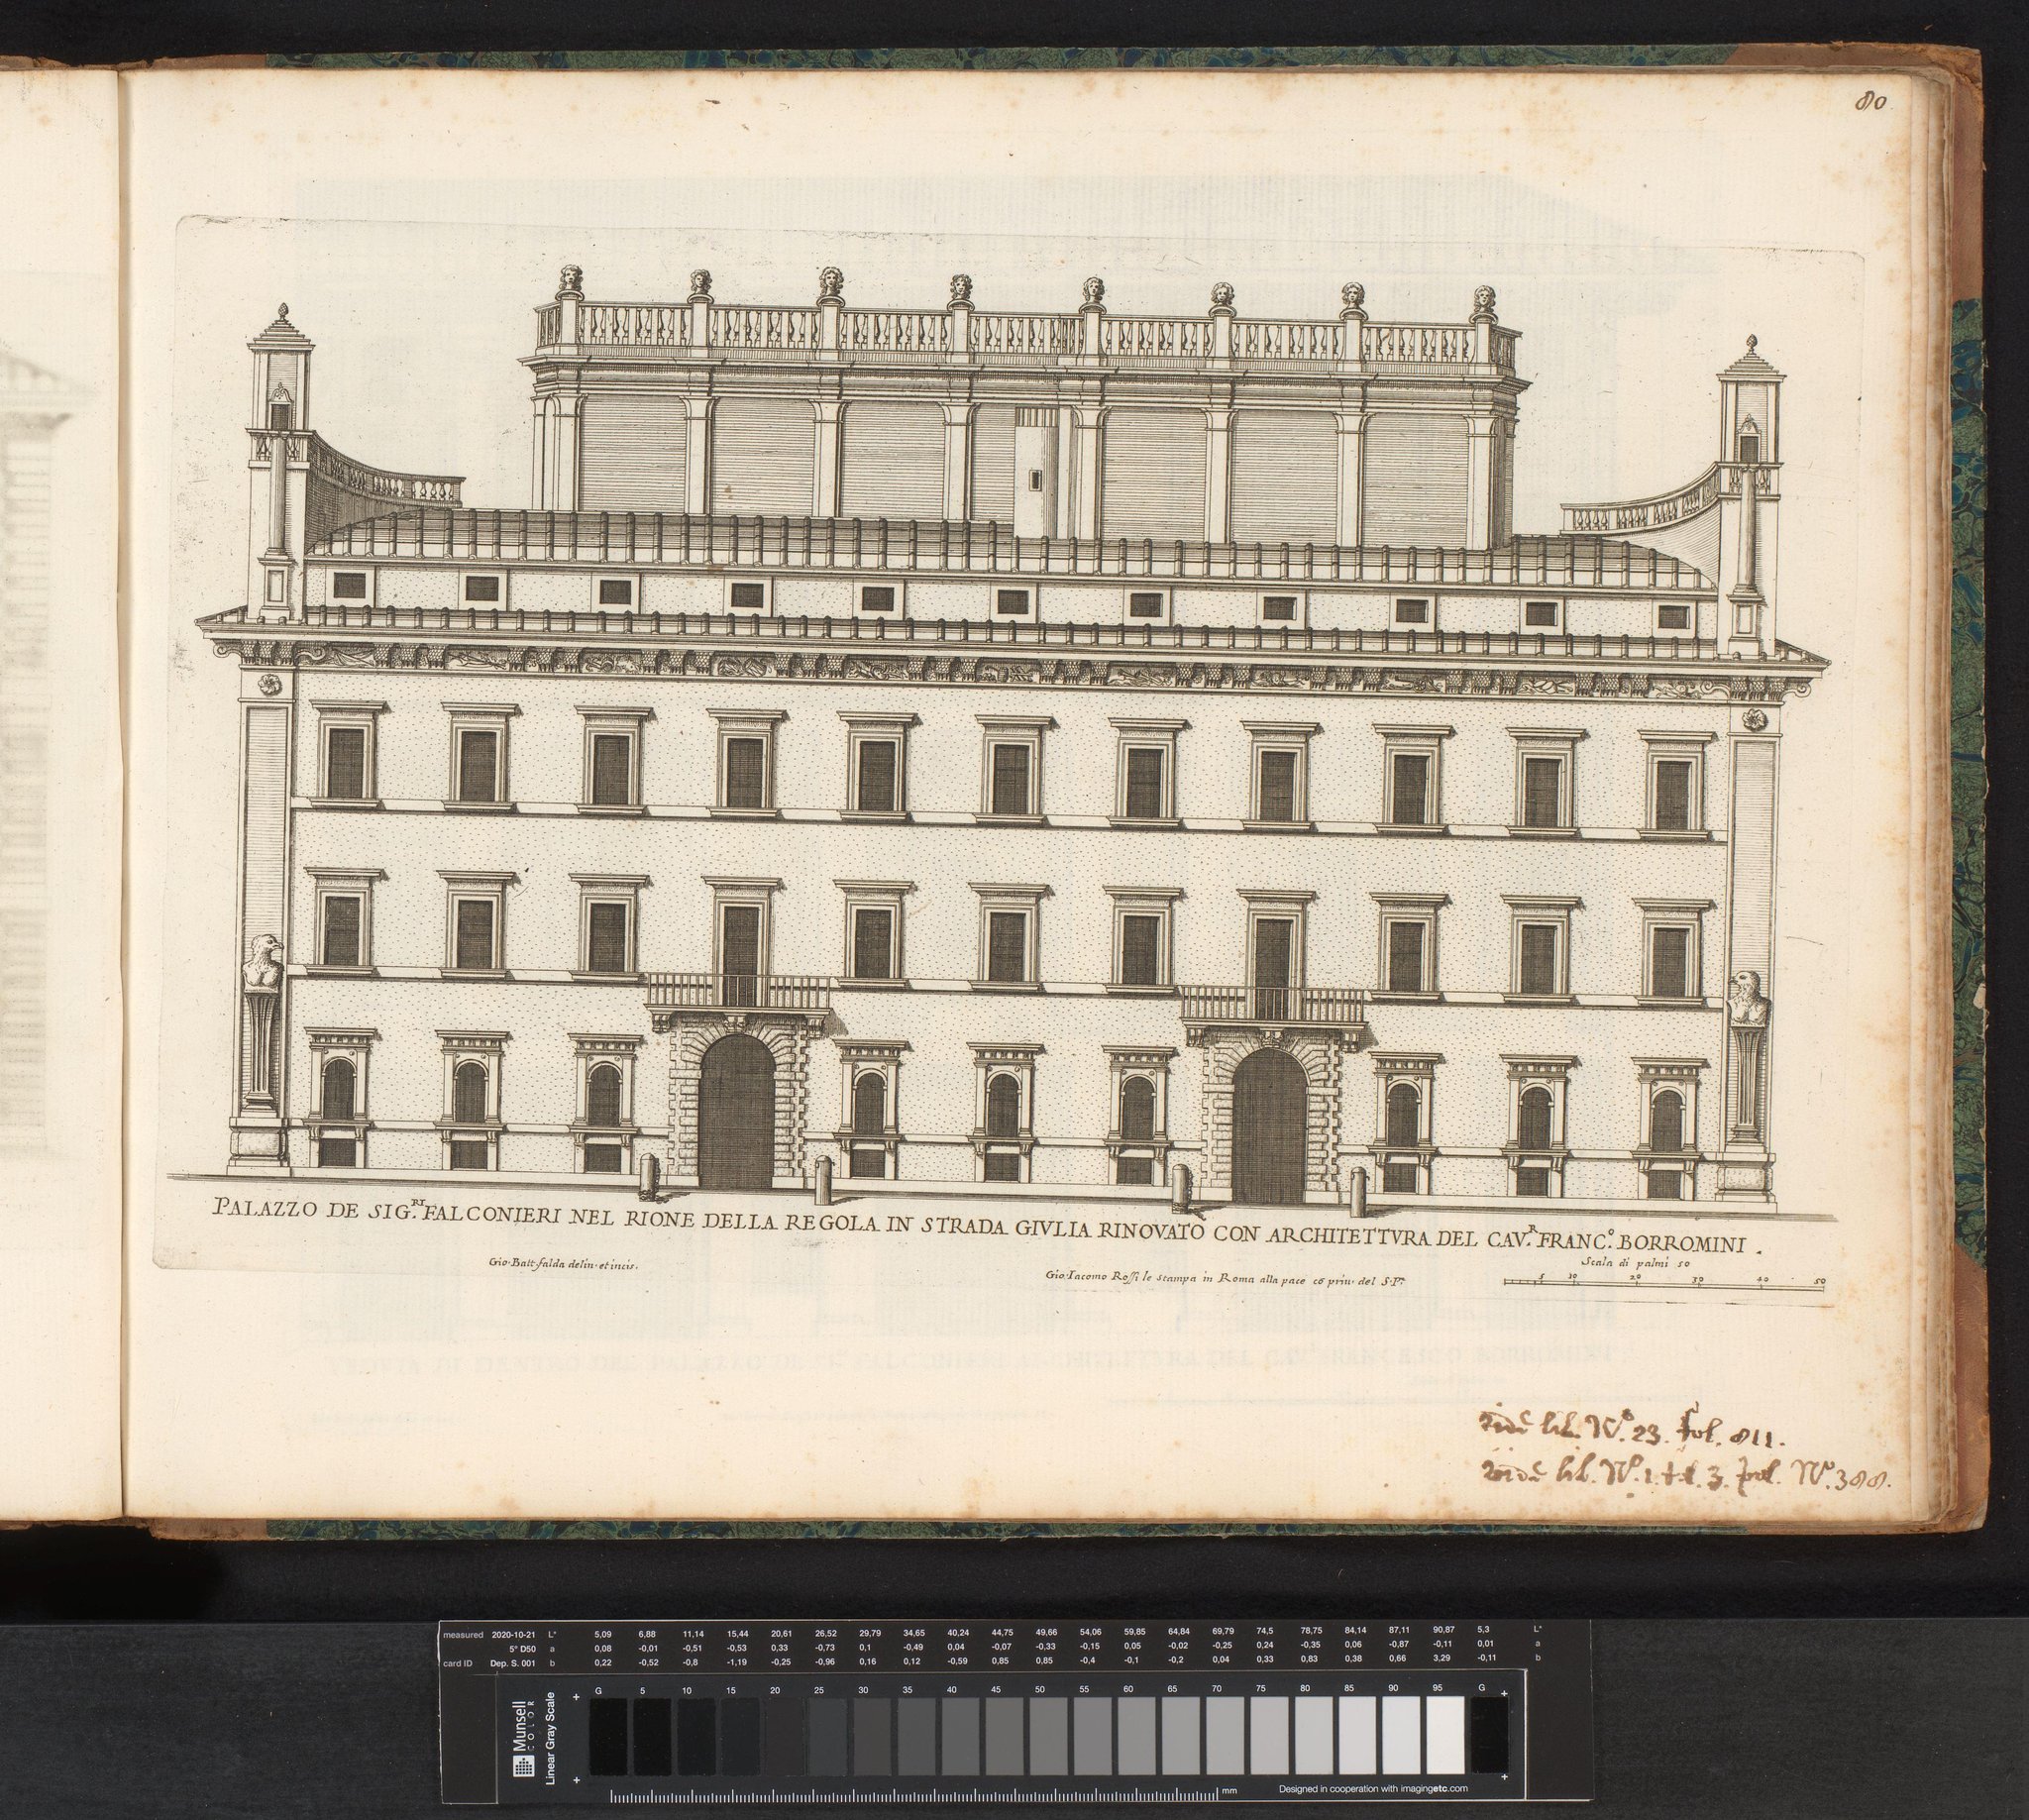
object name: print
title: Palazzo de sig.ri Falconieri nel Rione della Ragola in Strada Giuli (...)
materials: paper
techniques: etching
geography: vatican city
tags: palace, façade (of house or building)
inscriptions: number: ‘80’, inscription: ‘Ende lib. No. 23. fol. 811./ Ende lib. No. 1. fol. 3 [...] No. 388.’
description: Deze prent maakt deel uit van de reeks getiteld: Palazzi di Roma. Deze reeks bestaat uit twee boeken. Boek één getiteld: Palazzi di Roma dei più celebri architetti..., bestaat uit 44 prenten die worden toegeschreven aan Giovanni Battista Falda (naam staat enkel op prent 27) en uitgegeven door Giovanni Giacomo de'Rossi. Deze 44 prenten zijn bekend in twee staten (met en zonder nummer). Boek twee getiteld: Nuovi disegni dell'architetture... libro secondo, bevat 66 prenten door Giovanni Battista Falda en Simone Felice. Deze 66 prenten zijn bekend in twee staten (met en zonder nummer).